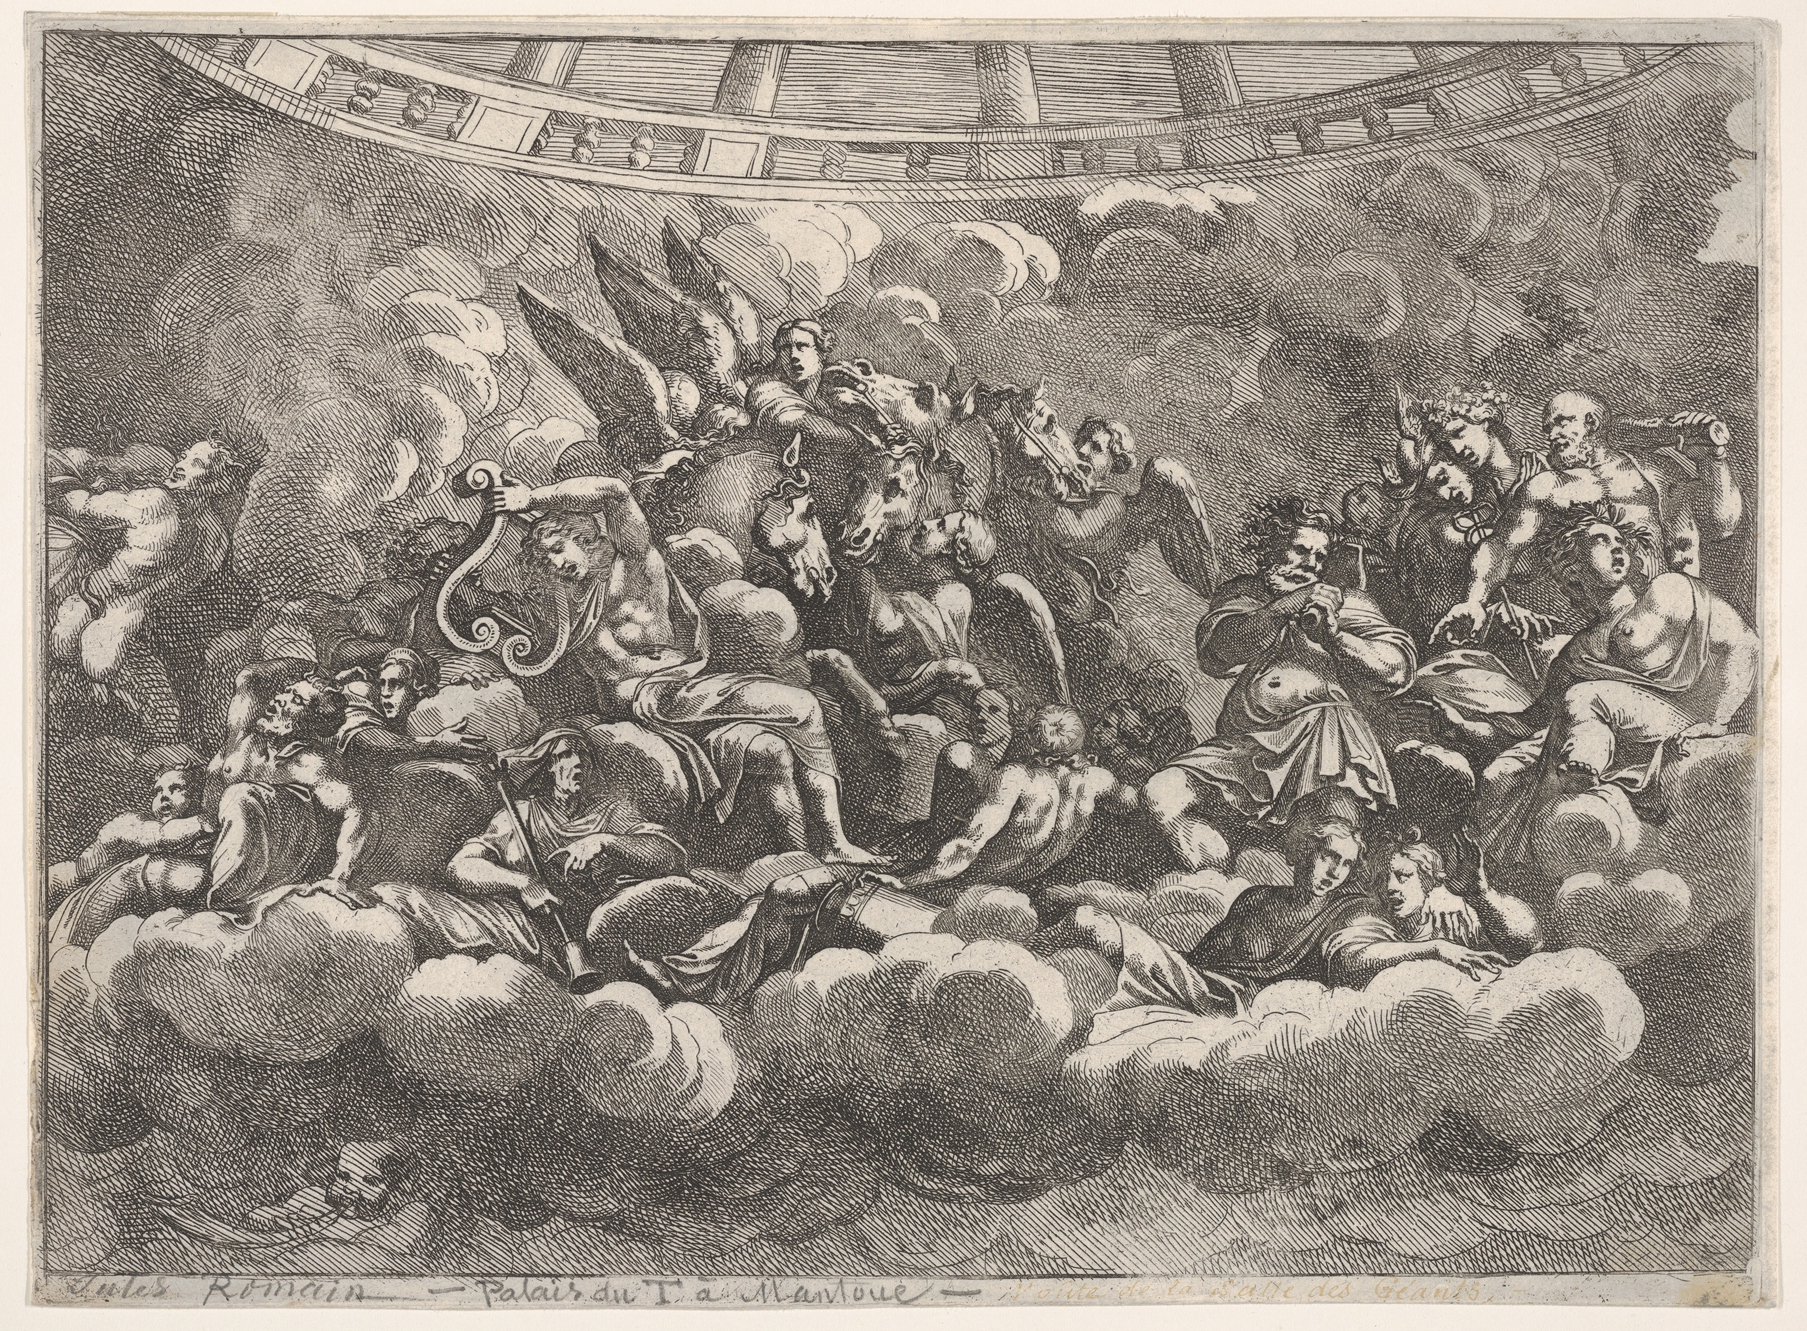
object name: print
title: Gathering of various Olympian gods and mythological figures among clouds, Apollo at center with his lyre, Vulcan, Mercury, Hercules, and Hermes to right, various figures below, horses and attendants behind in center, from "Giove che fulmina li giganti", after the frescoes on the ceiling of the Sala dei Giganti designed by Giulio Romano for the Palazzo del Te, Mantua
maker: pietro santi bartoli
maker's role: artist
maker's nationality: italian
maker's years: 1615-1700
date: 1680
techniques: etching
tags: apollo,hermes,hercules,mercury,vulcan